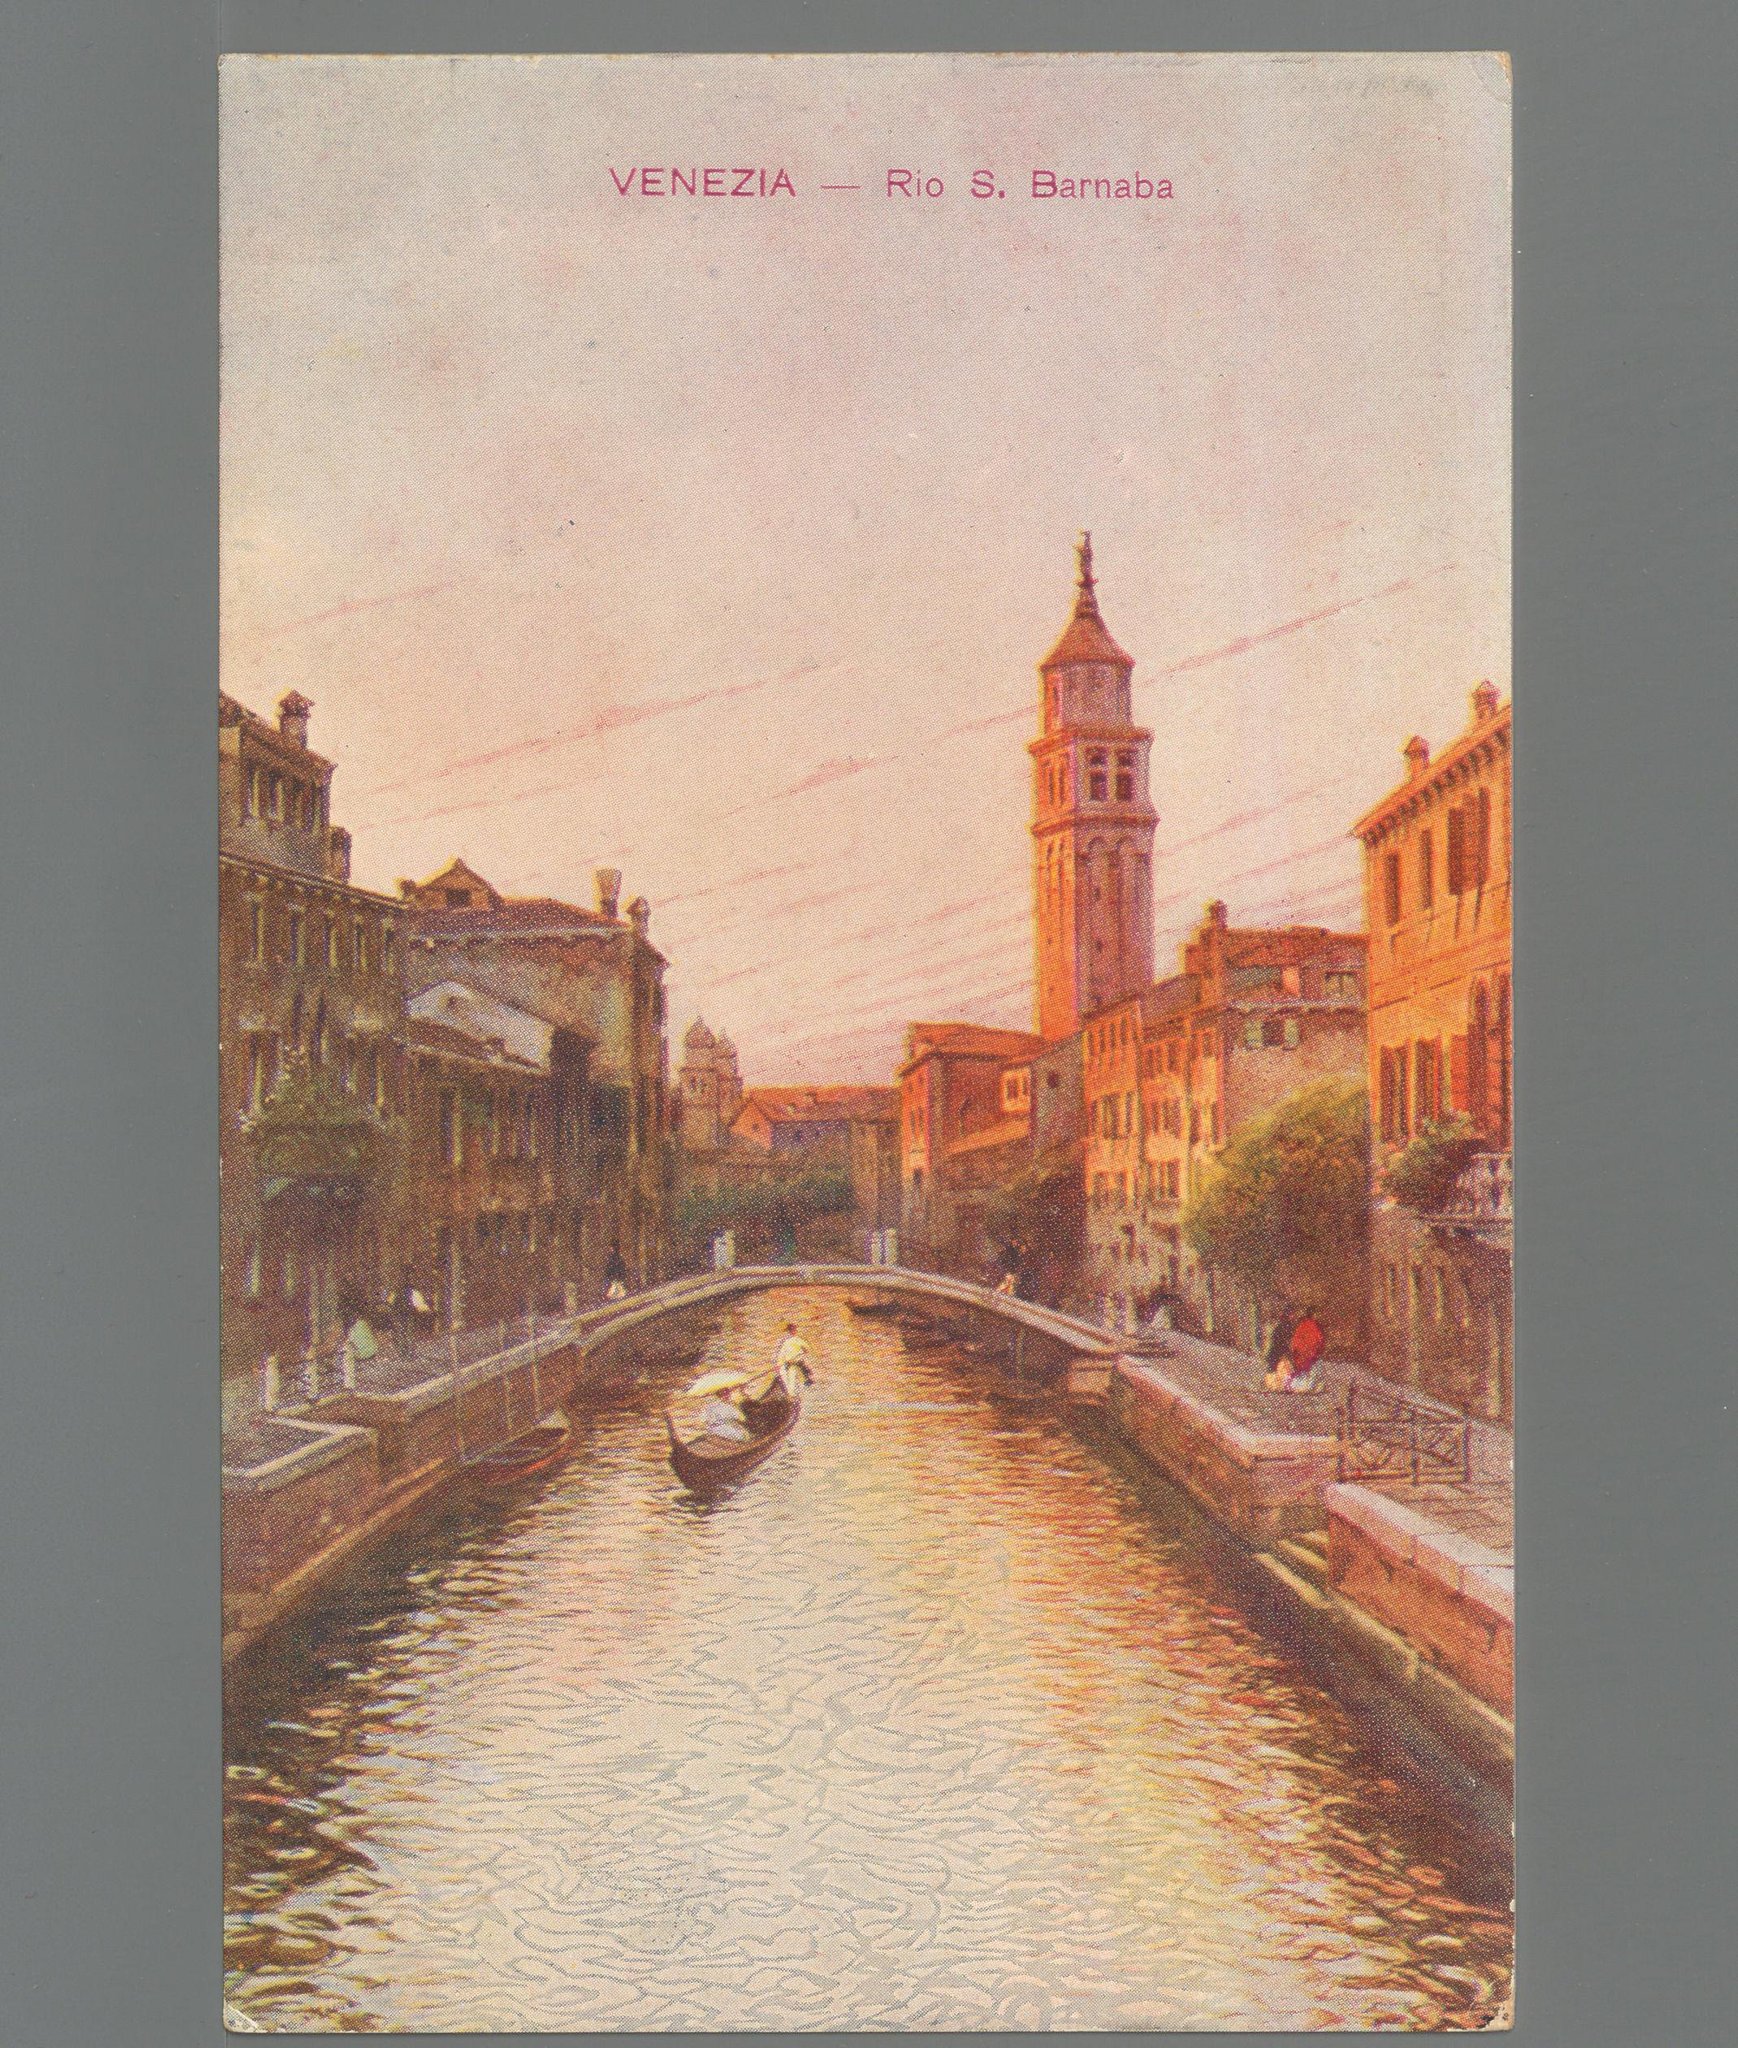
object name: ansichtkaart, prentbriefkaart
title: Venezia. Rio S. Barnaba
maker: Anonymous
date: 1906-1930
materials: cardboard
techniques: three-color autotype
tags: river, church (exterior), city-view, and landscape with man-made constructions (+ city(-scape) with figures, staffage), venice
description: Deze kaart hoort misschien bij het omslag RP-F-00-20565.